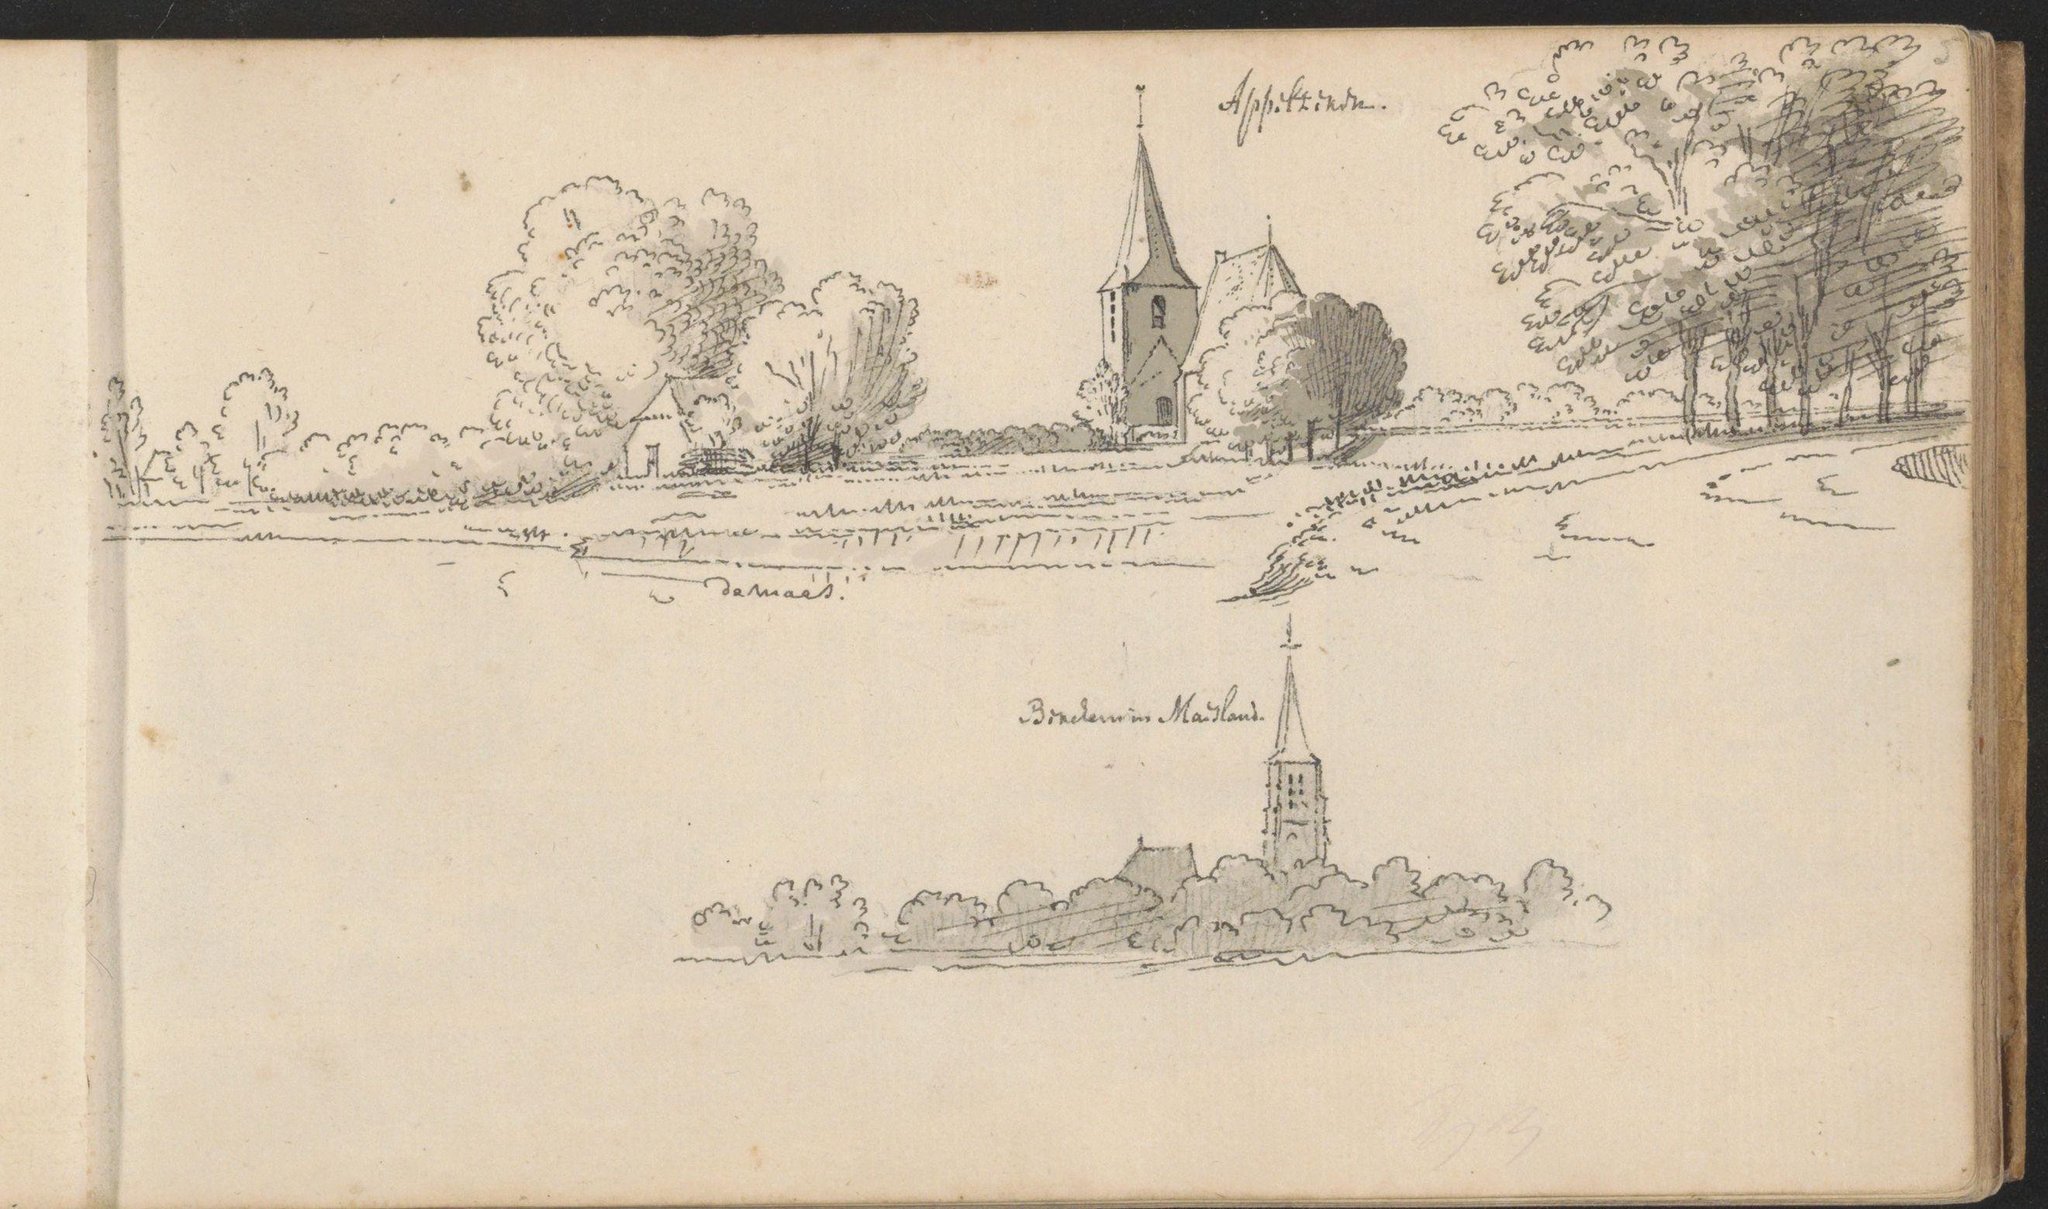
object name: sketchbook leaf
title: Gezicht op Appeltern en gezicht op Berchem in Maesland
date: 1701-1759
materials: ink, paper, pencil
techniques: brush, pen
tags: prospect of village, silhouette of village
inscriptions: annotation: ‘Appeltern/ Berchem in Maesland’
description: Blad 5 recto uit een schetsboek met 65 bladen.